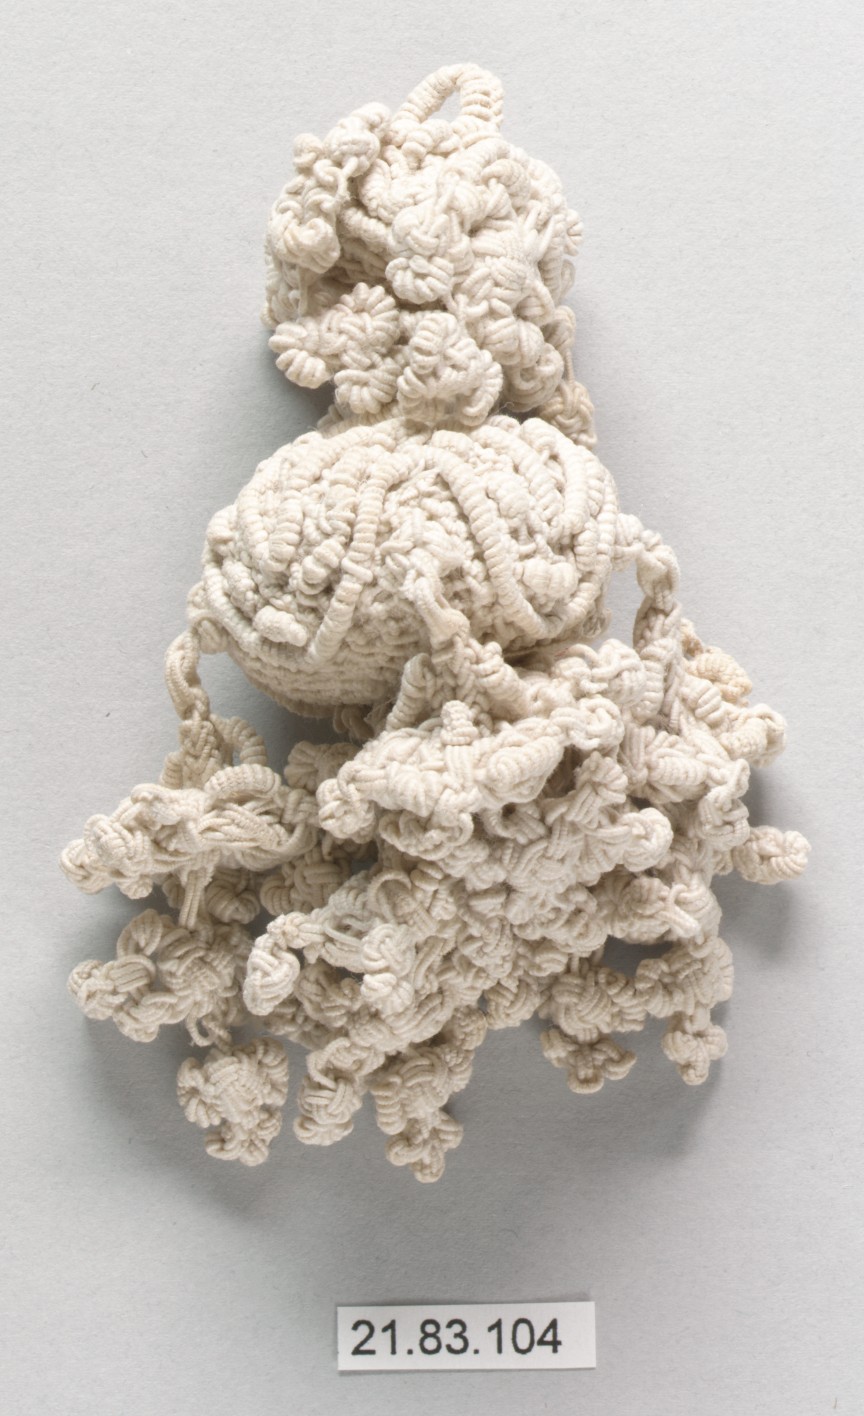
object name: tassel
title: Pair of tassels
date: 1601-1700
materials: linen